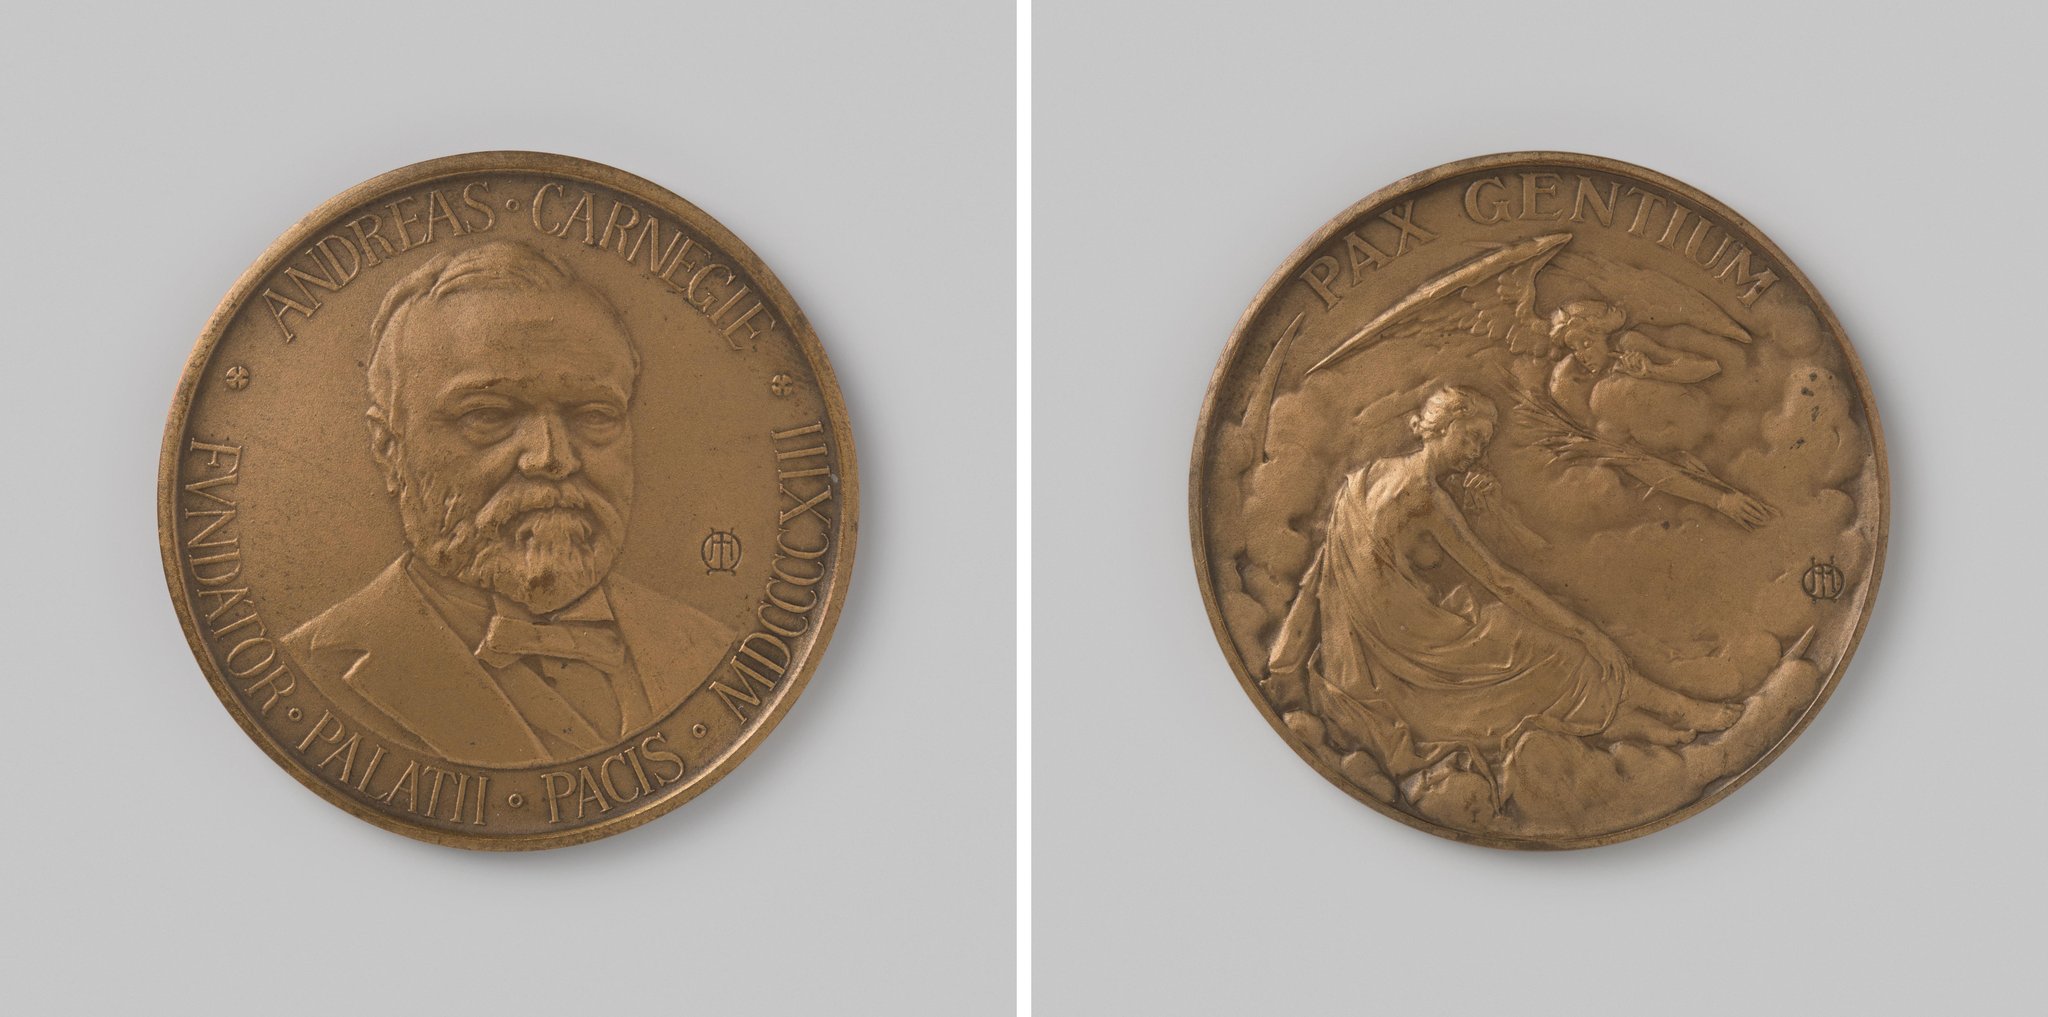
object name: history medal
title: Opening van het Vredepaleis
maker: herman makkink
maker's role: medailleur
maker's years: 1893-1981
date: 1913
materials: bronze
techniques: striking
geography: voorschoten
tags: filantroop, industrieel, andrew carnegie, vredespaleis, eerste steen leggen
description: Opening van het Vredepaleis, 1913. Bronzen penning, voorzijde: portret, borstbeeld van Andrew Carnegie, binnen omschrift; keerzijde: in wolken zittende vrouw met dalende engel, onder opschrift.